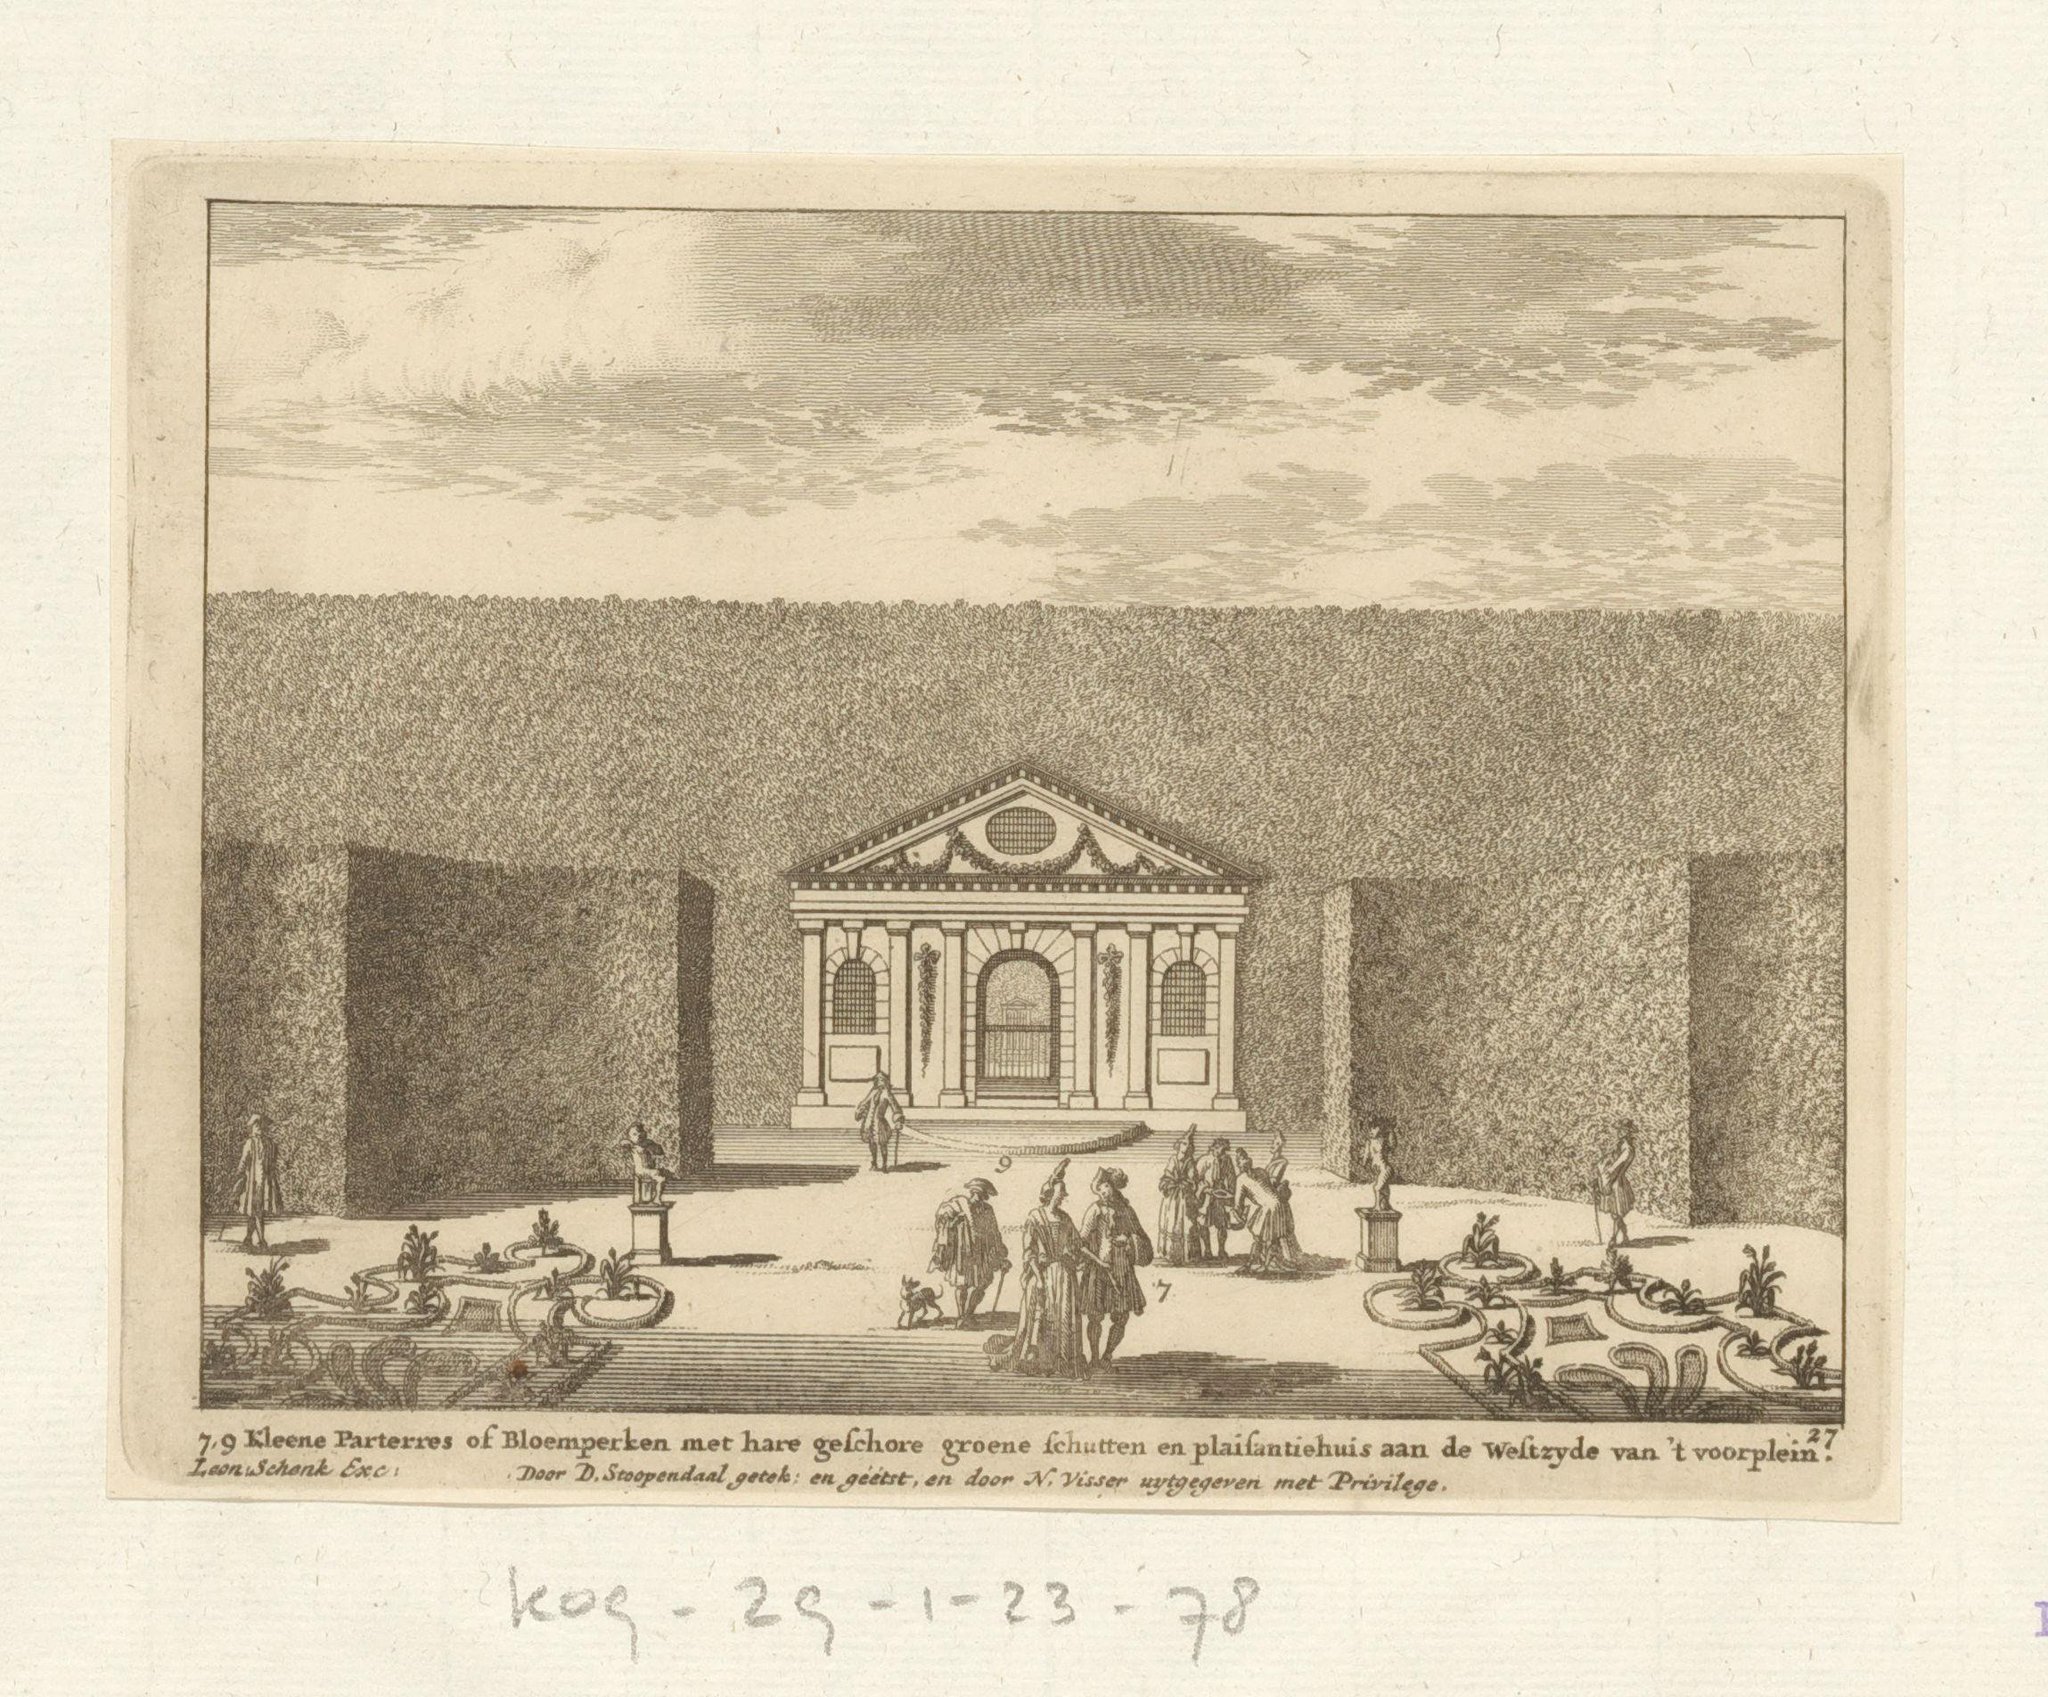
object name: print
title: Gezicht op een deel van de tuinen met het tuinhuis op landgoed Clingendael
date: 1706-1767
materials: paper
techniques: engraving, etching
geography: amsterdam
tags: french or architectonic garden; formal garden, garden buildings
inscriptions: collector's mark: Lugt 1641, stamp, stamp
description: Gezicht op een deel van de tuinen met het tuinhuis op landgoed Clingendael te Den Haag. In de tuin lopen elegante figuren. Onderwerpsrubrieken binnen de Atlas Zeden en Gewoonten: Zeden en Gewoonten in Engeren Zin, De Woning. Kastelen en buitenplaatsen. Holland.